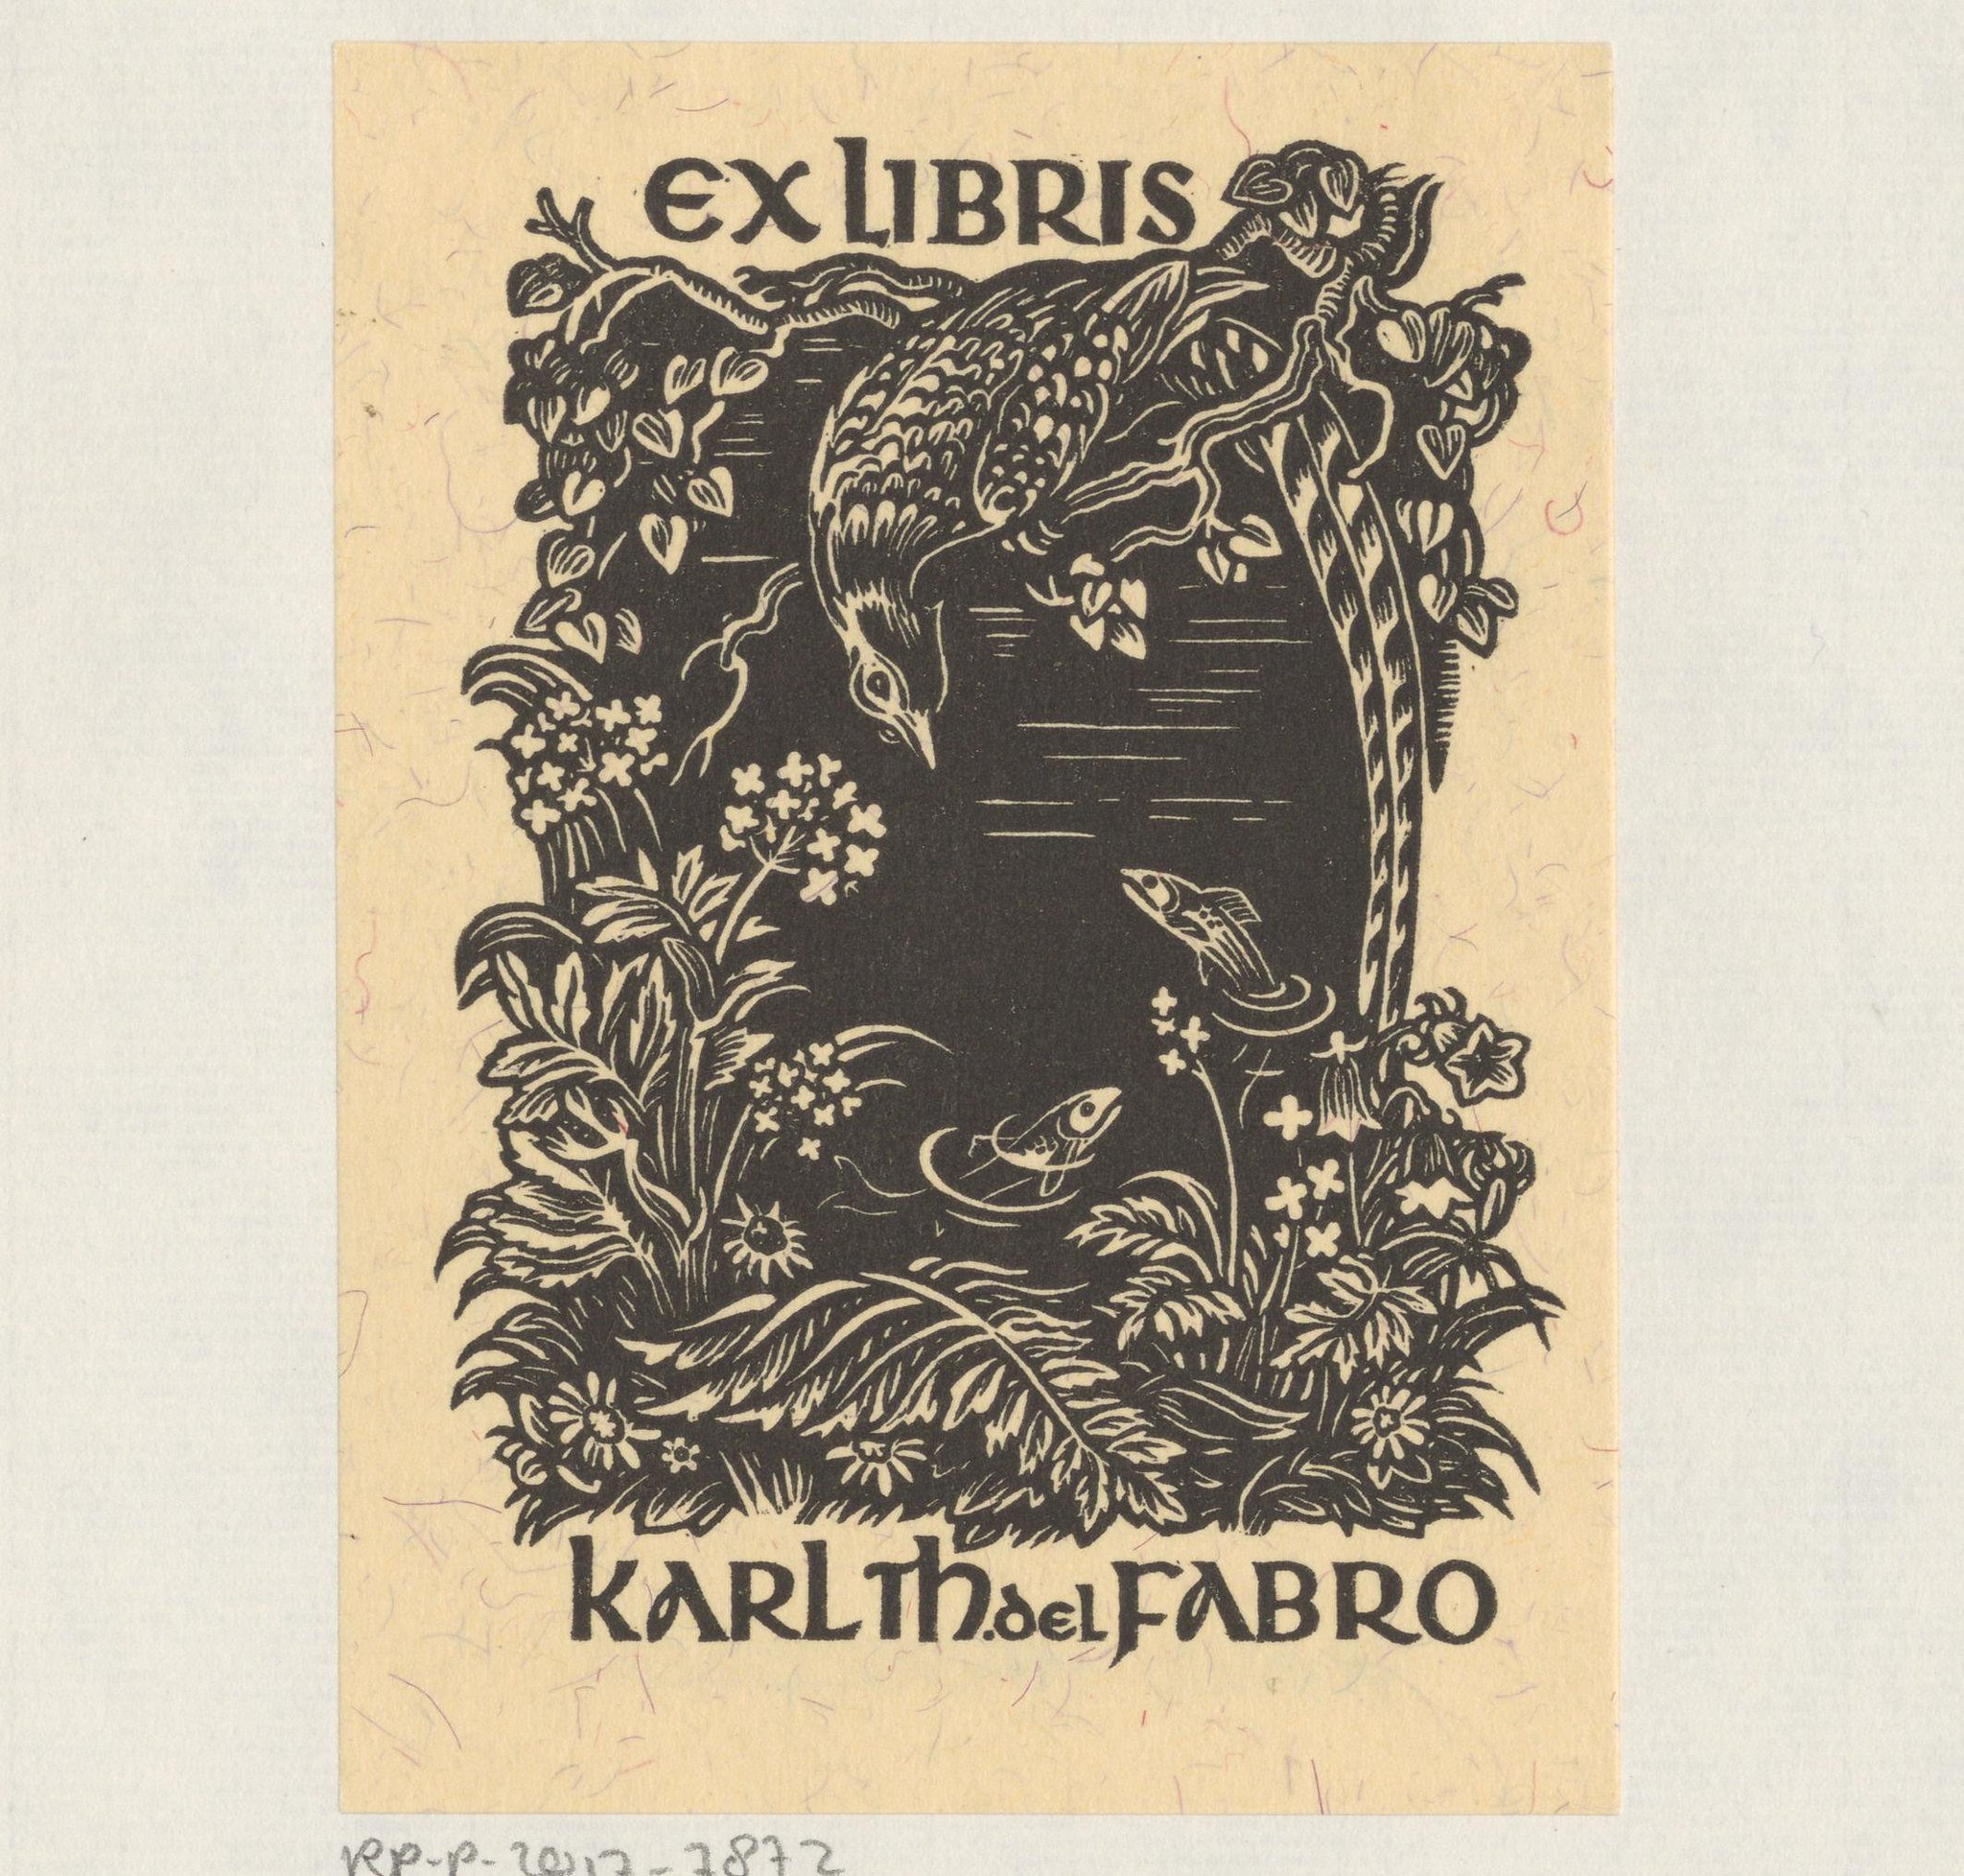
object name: bookplate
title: Ex libris van Karl Th. del Fabro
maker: lizzi kuhn-klapschy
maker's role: print maker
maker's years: 1926-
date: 1936-1999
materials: paper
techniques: woodcut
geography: austria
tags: fishes, walker and runner birds: pheasant, plants and herbs